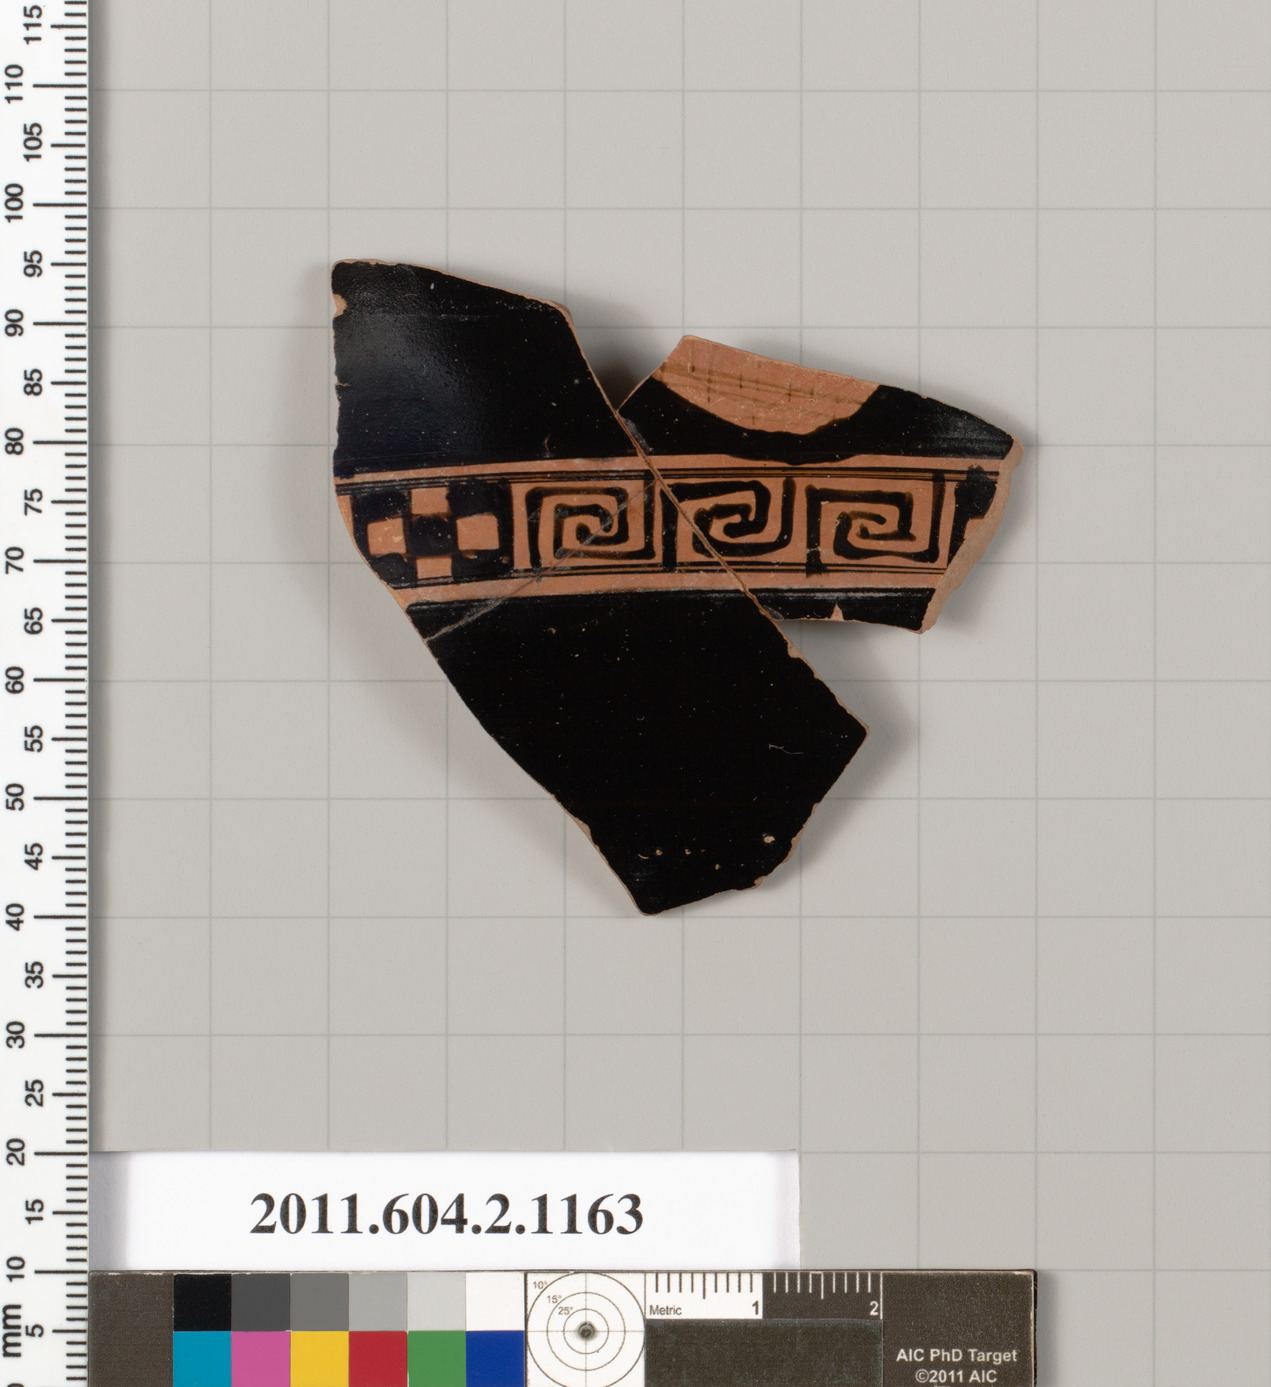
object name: skyphos fragment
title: Terracotta fragment of a skyphos (deep drinking cup)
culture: greek, attic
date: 475-451 BCE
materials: terracotta